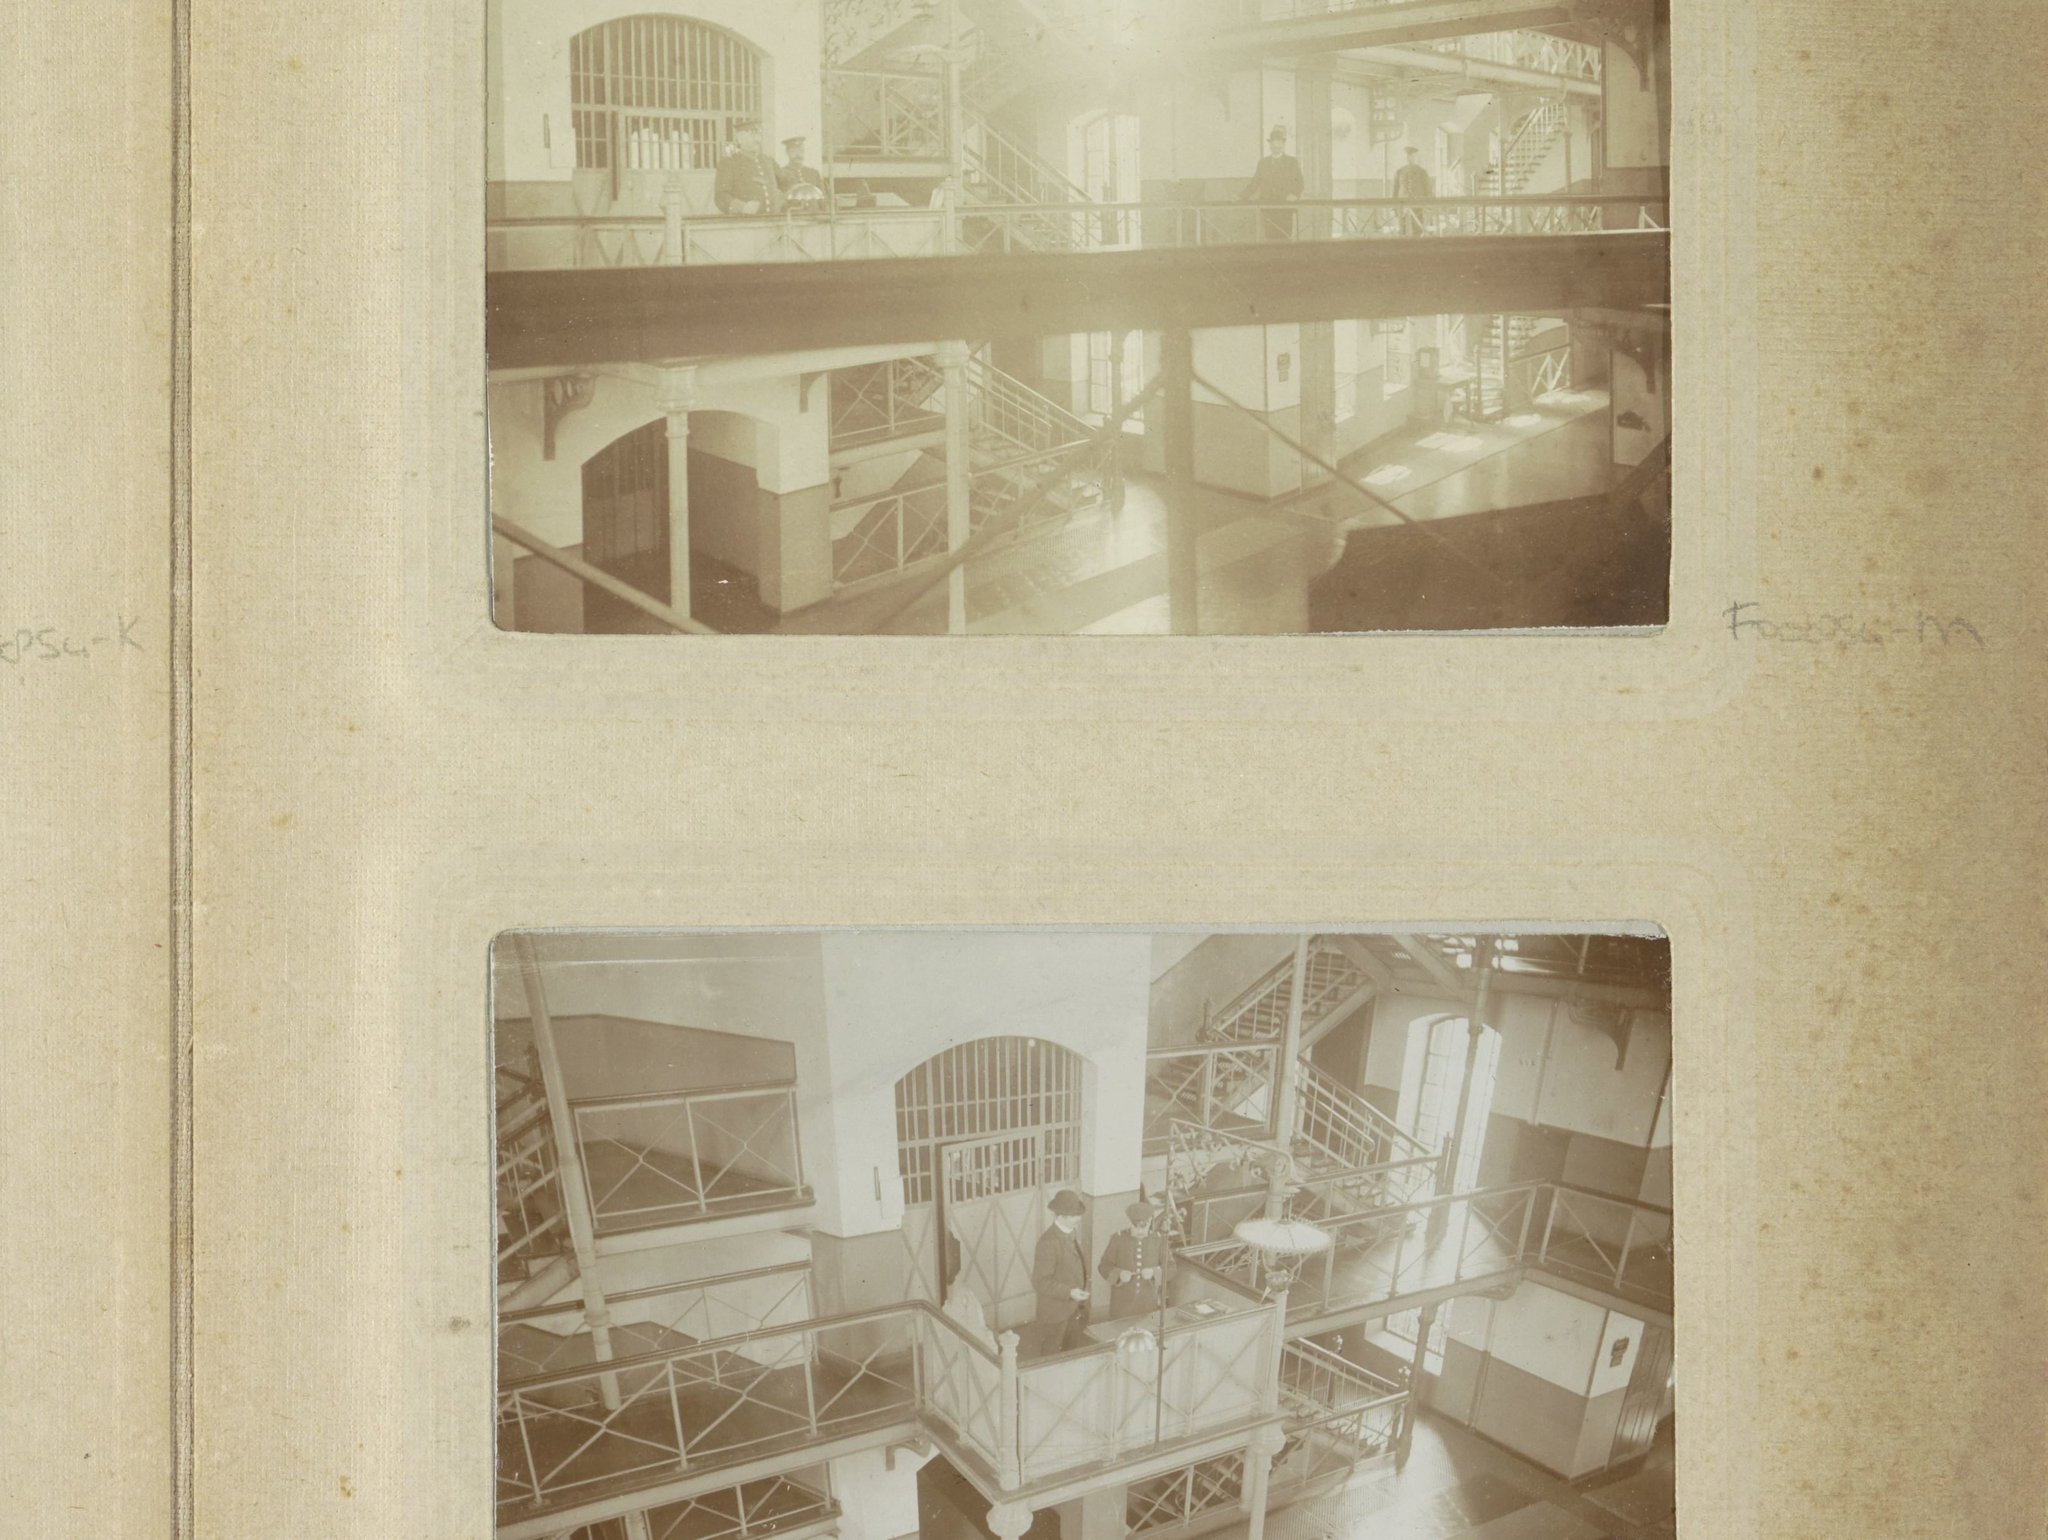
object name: photograph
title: Interieur van de gevangenis van Oslebshausen met gevangenbewaarders op een loopbrug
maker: Anonymous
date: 1890-1910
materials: cardboard, paper, photographic support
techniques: daylight paper print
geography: oslebshausen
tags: prison, jail, prison personnel: jailers, warders, guards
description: Onderdeel van Fotoalbum van Carl Heinrich Fliegenschmidt, gevangenisdirecteur te Oslebshausen.